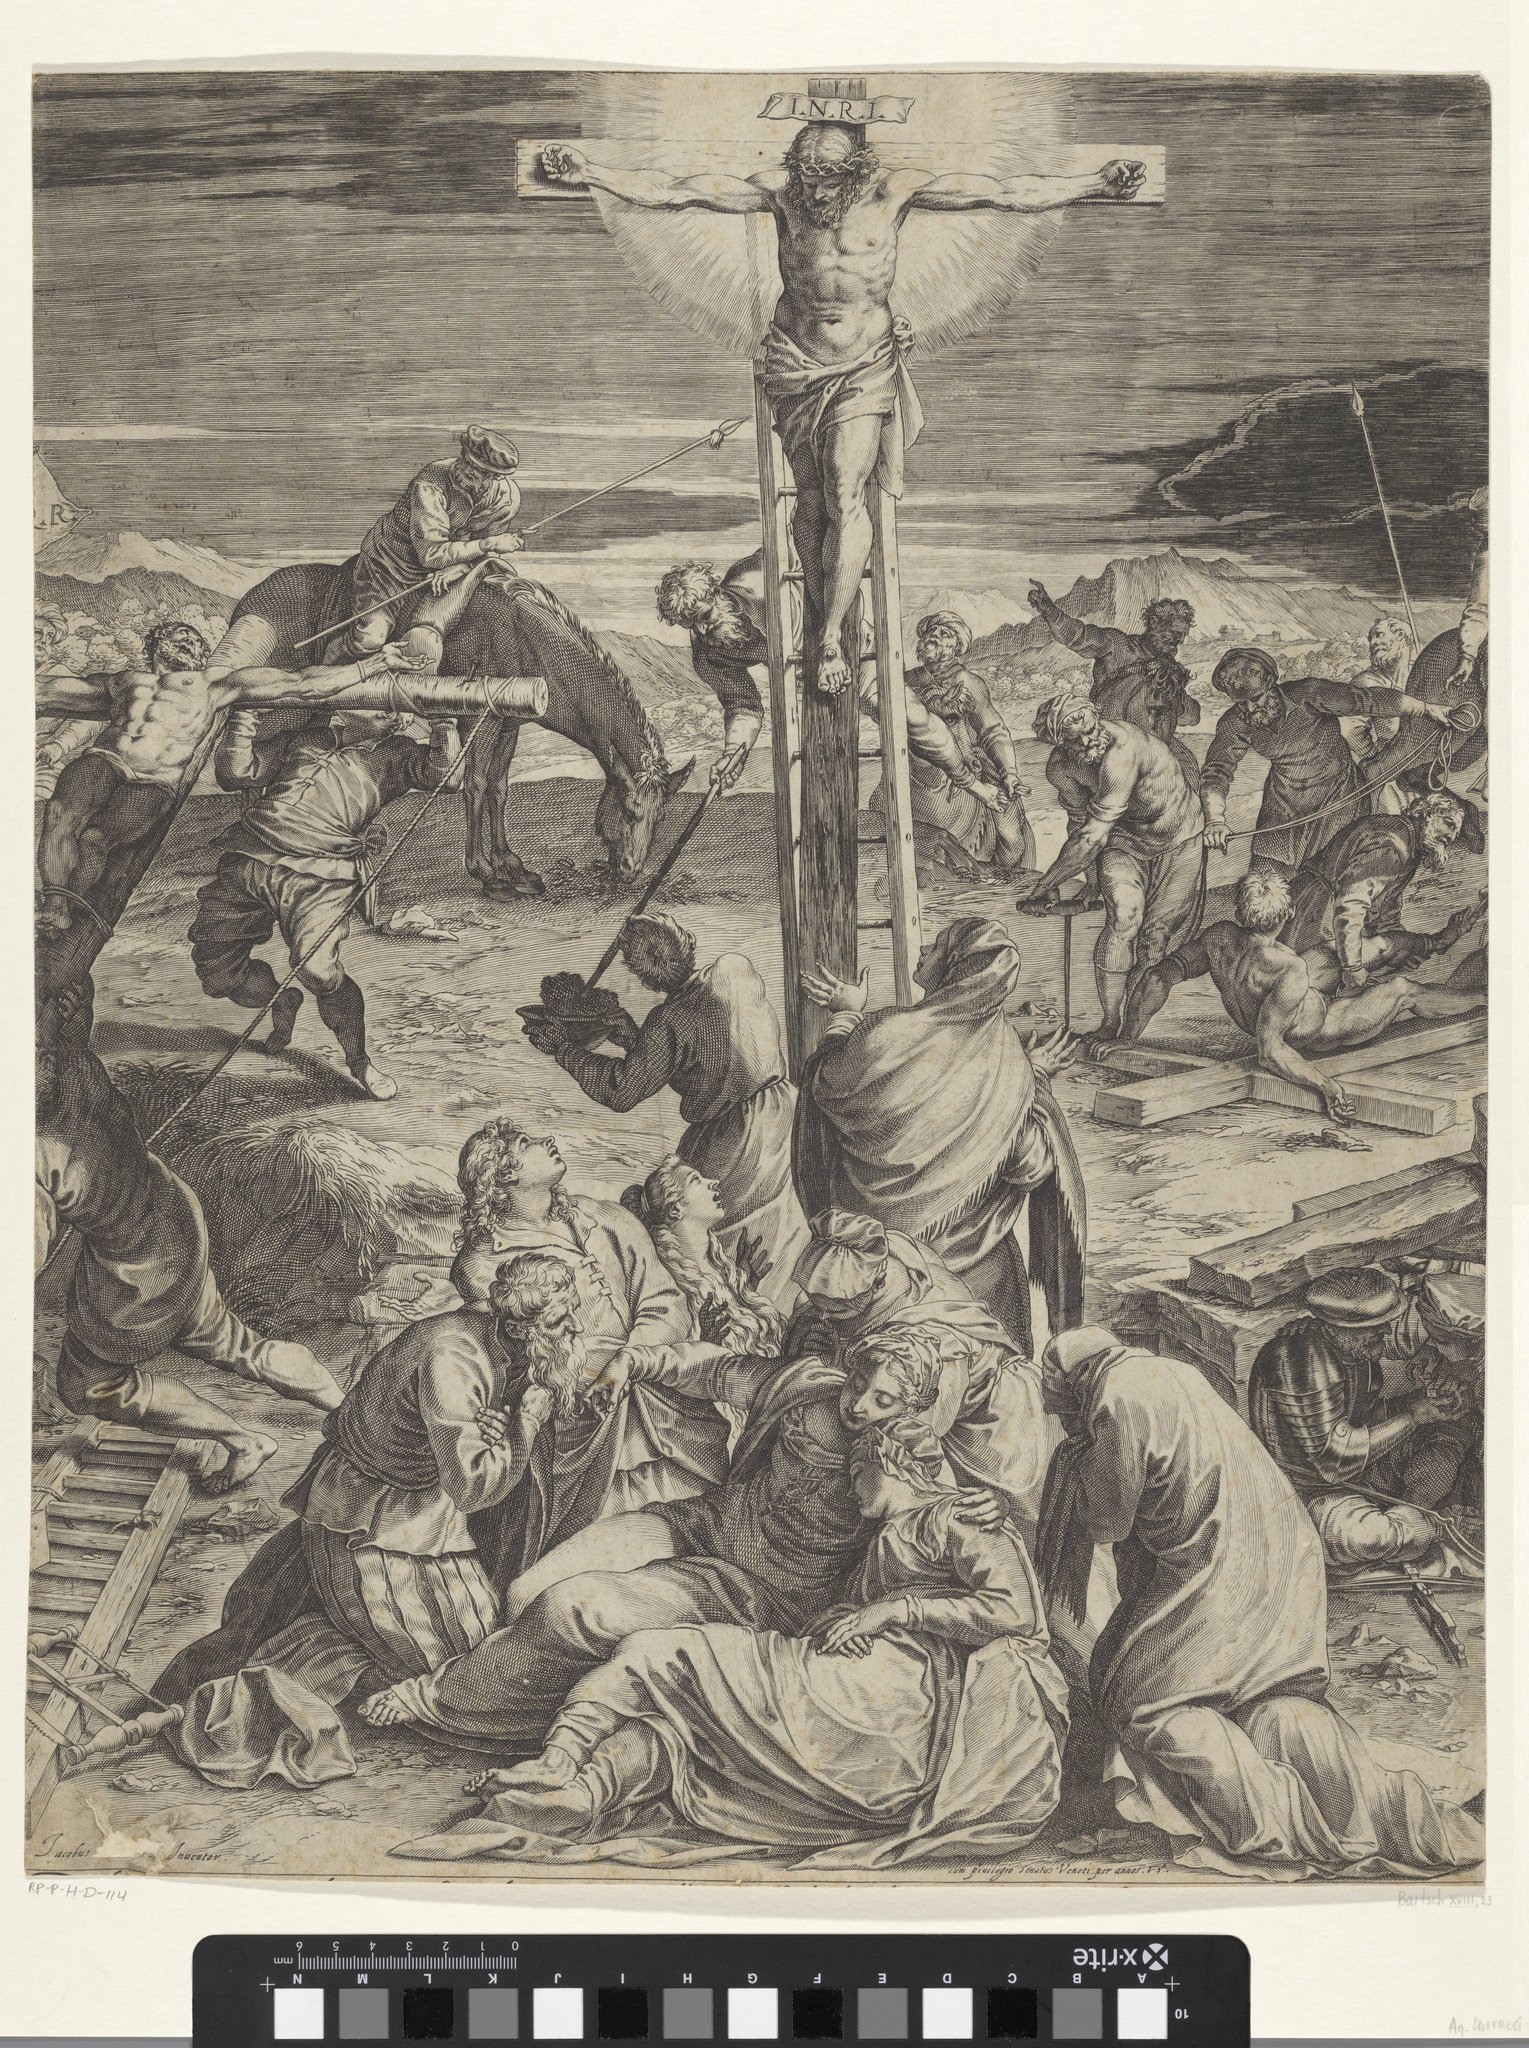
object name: print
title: Kruisiging van Christus (middendeel)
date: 1582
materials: paper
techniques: engraving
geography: italy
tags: the crucifixion of christ: christ's death on the cross; golgotha (matthew 27:45-58; mark 15:33-45; luke 23:44-52; john 19:25-38)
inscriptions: collector's mark: Lugt 11, collector's mark: Lugt 10, collector's mark: ‘Hinloopen’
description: Kruisdood van Christus op Golgota. Christus hangt aan het kruis, links en rechts van hem worden de twee misdadigers gekruisigd. Longinus staat op het punt zijn lans in de zijde van Christus te steken. Een groep mannen op paarden en ezels kijkt toe. De Maria's en Johannes treuren onder het kruis. Tekst in het Latijn in ondermarge.